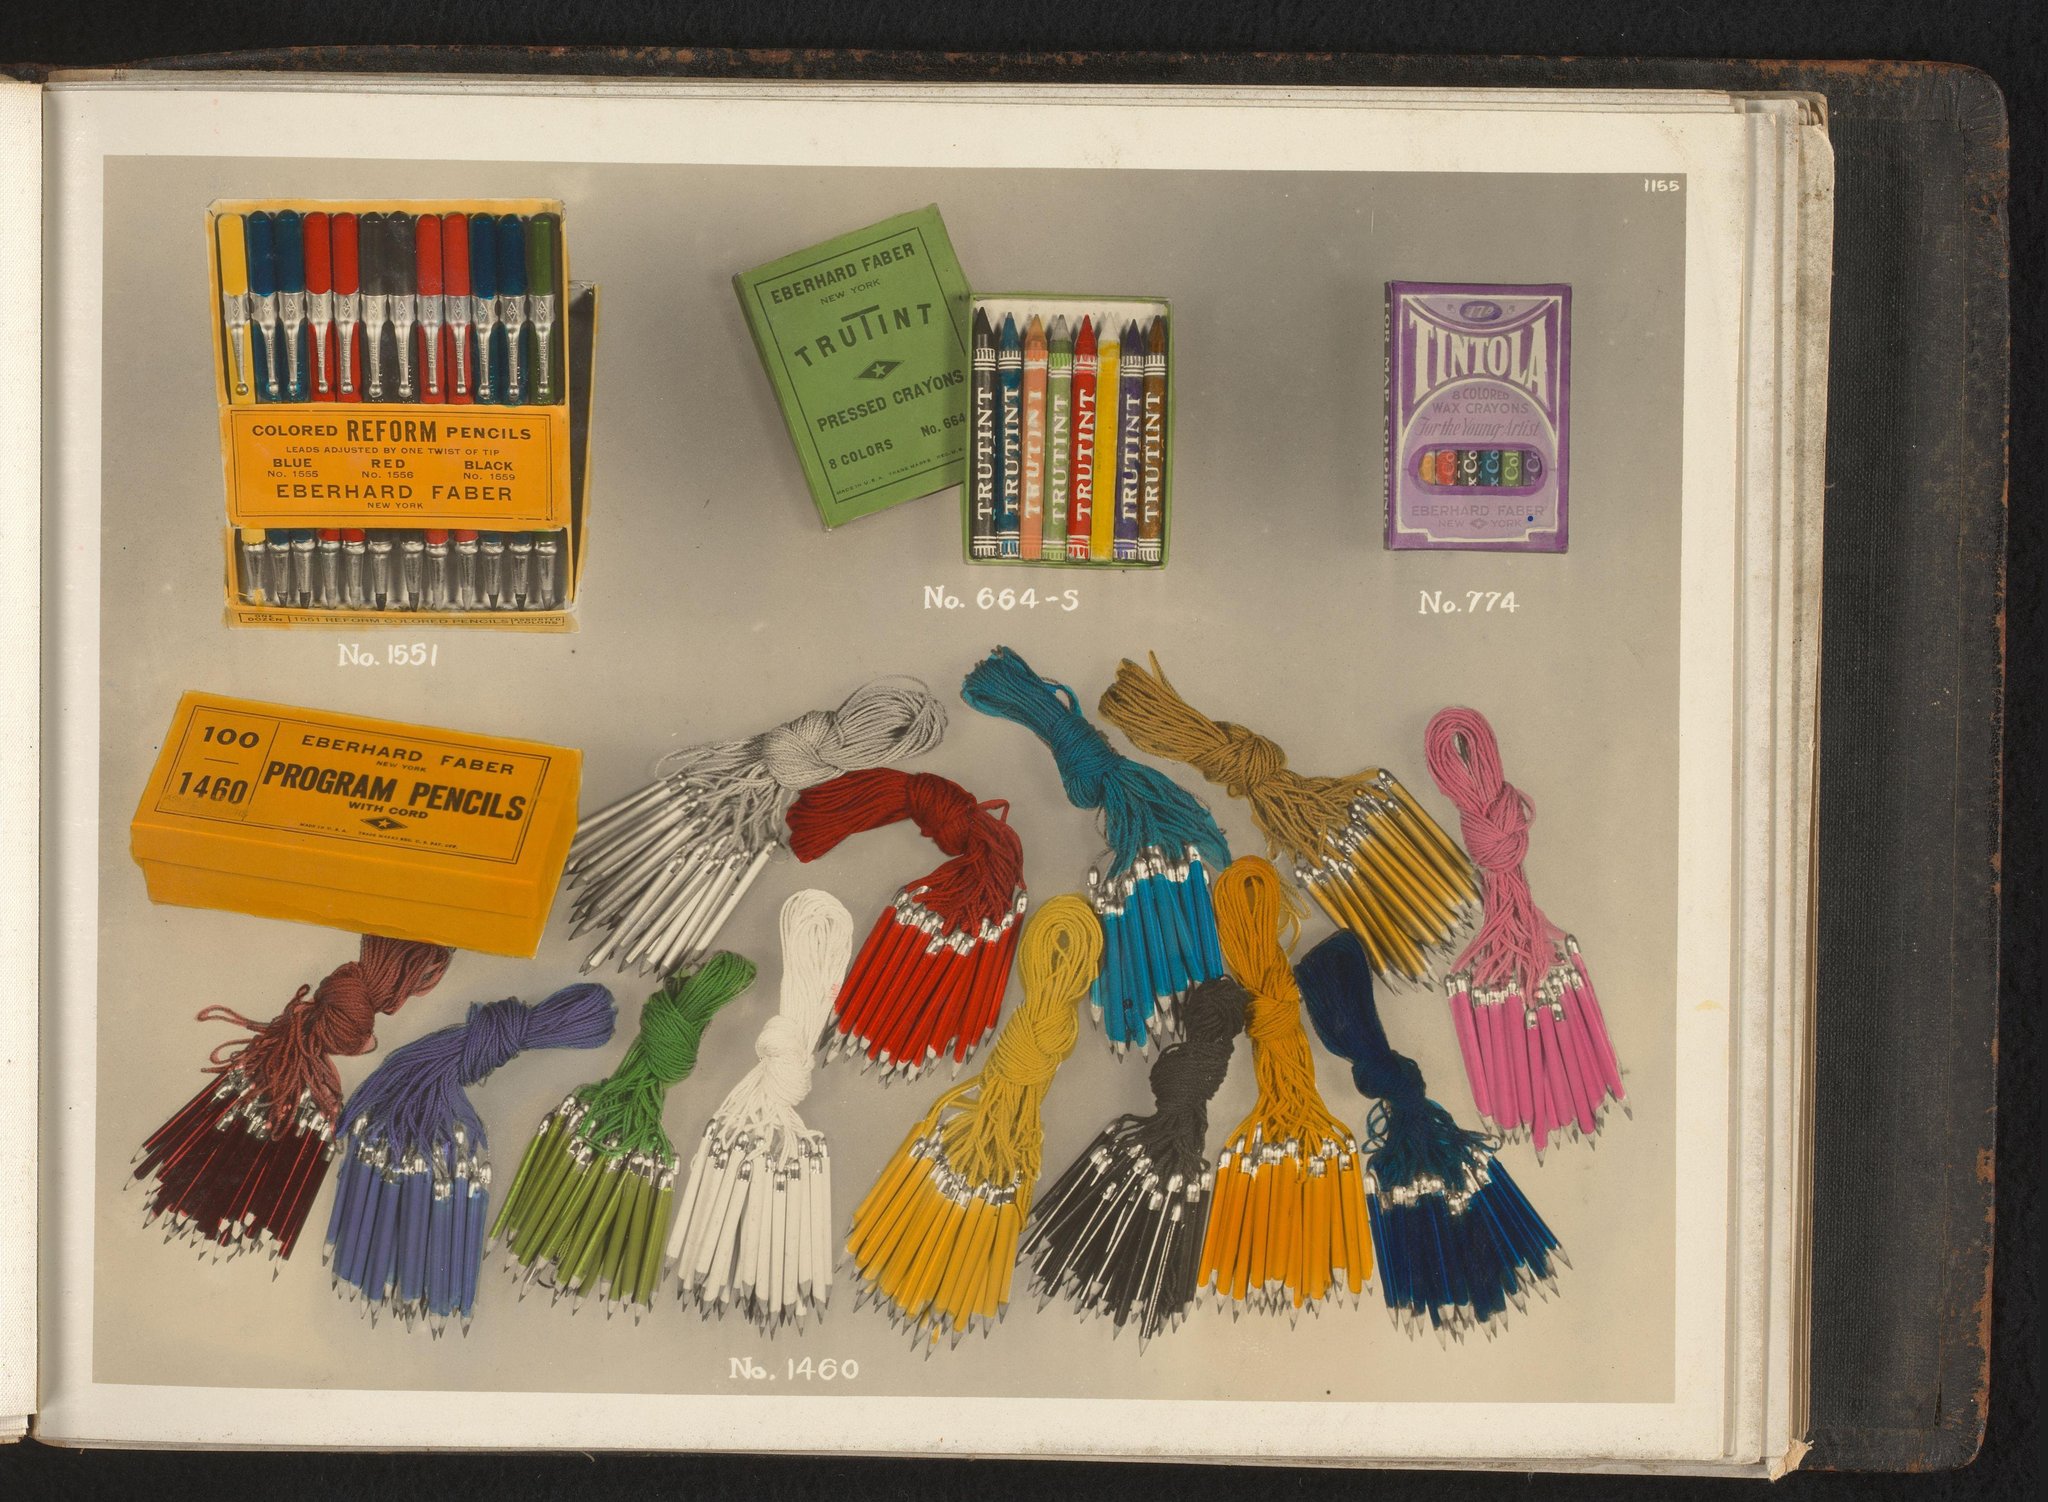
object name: album leaf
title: Sets met potloden van Eberhard Faber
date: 1915-1935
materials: paper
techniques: gelatin silver print, hand coloring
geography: springfield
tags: pencil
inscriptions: number: ‘1155’, stamp: ‘Paramount/ Commercial Studios/ 145 Chestnut St./ Springfield - Mass.’